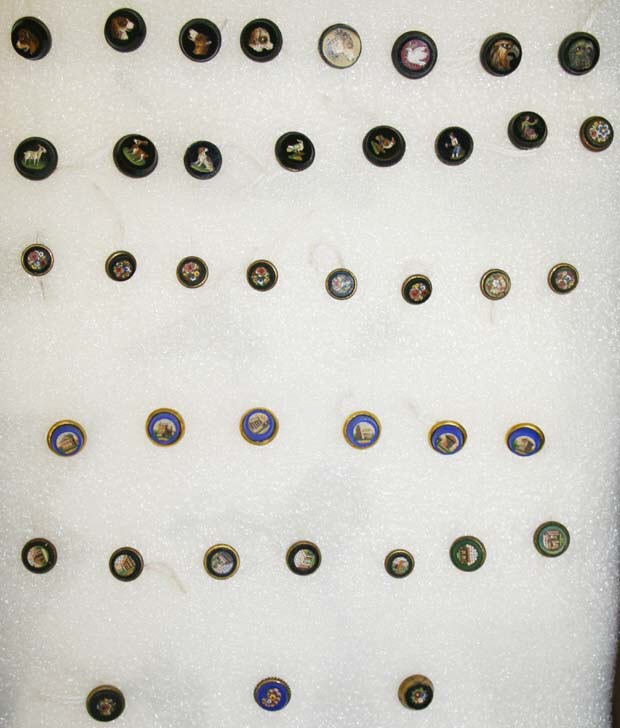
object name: button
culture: italian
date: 1860